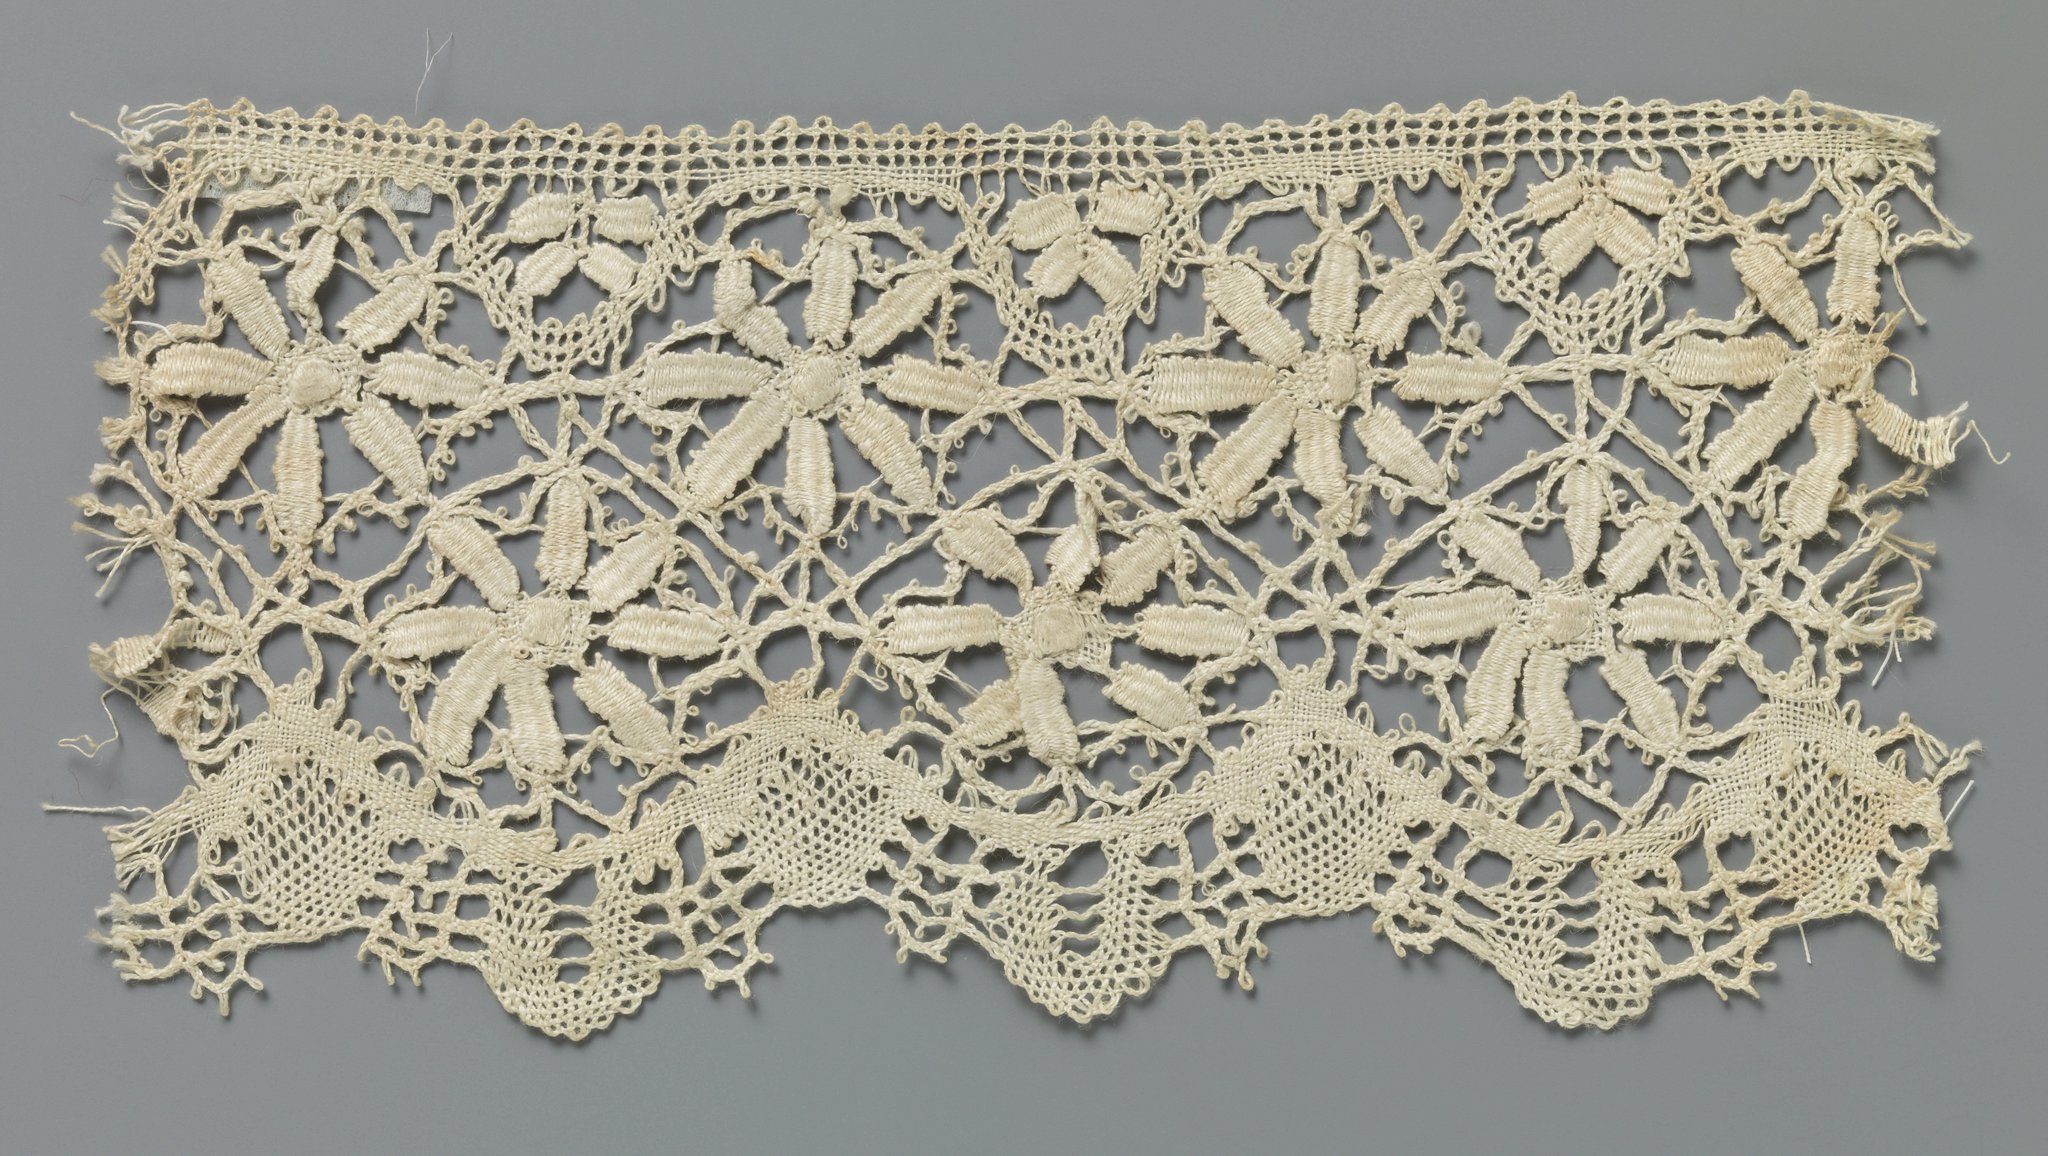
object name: strip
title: Strook kloskant met dubbele rij bloemen met acht bloemblaadjes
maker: Anonymous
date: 1850-1899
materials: linen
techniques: lace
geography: belgium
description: Strook naturelkleurige kloskant, Cluny-kant. Het zich herhalende patroon bestaat uit een dubbele rij bloemen met acht bloemblaadjes, gemaakt in vormslag. De bloemen staan in een netwerk van lange en kortere gepicoteerde vlechten, die min of meer ruitvormige velden vormen, met in elk veld één bloem. Langs de onderzijde van de strook loopt een regelmatig golvende sierband, die tevens de schulpenrand vormt. Elke schulp bestaat uit kleinere lobben die afwisselend gevormd worden door een boogje in netslag, een boogje gemaakt met een vlechtwerkje en een boogje in netslag met een opengewerkt centrum. De bovenzijde van de strook is recht afgewerkt.